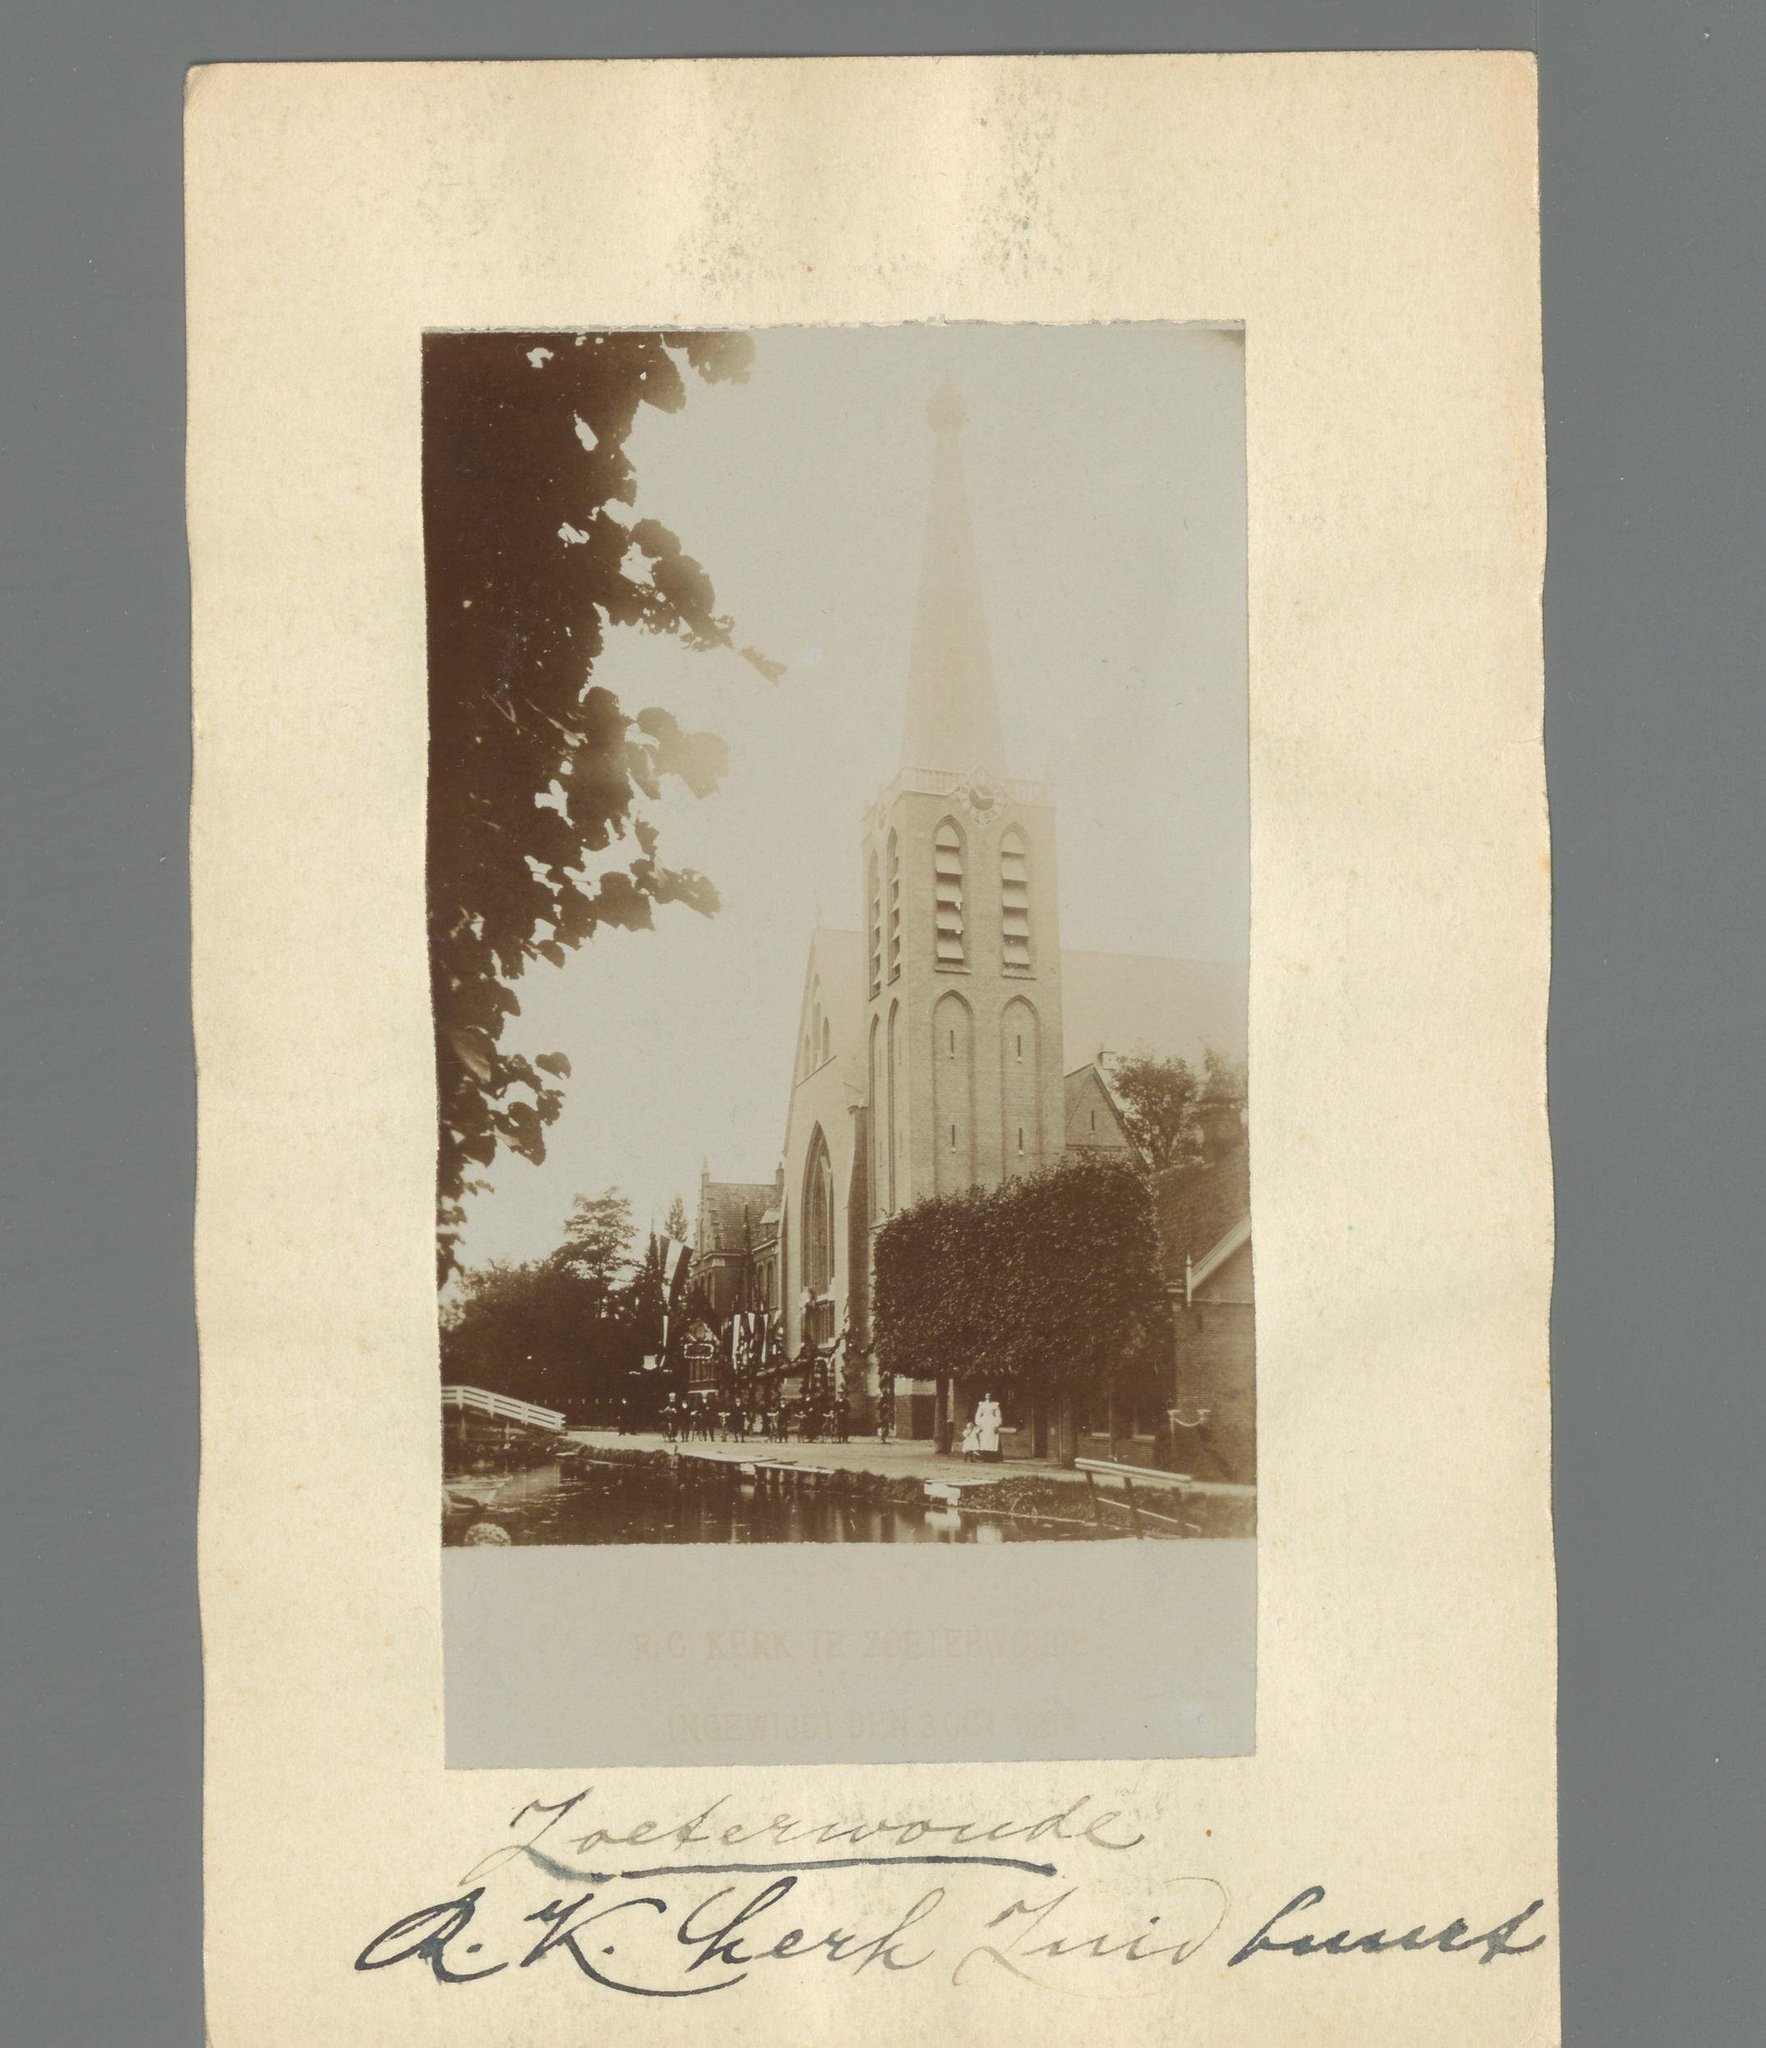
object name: ansichtkaart, prentbriefkaart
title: Zoeterwoude. R.K. kerk Zuidbuurt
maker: Anonymous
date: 1892-1905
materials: paper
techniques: collodion silver print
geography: zoeterwoude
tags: church (exterior)